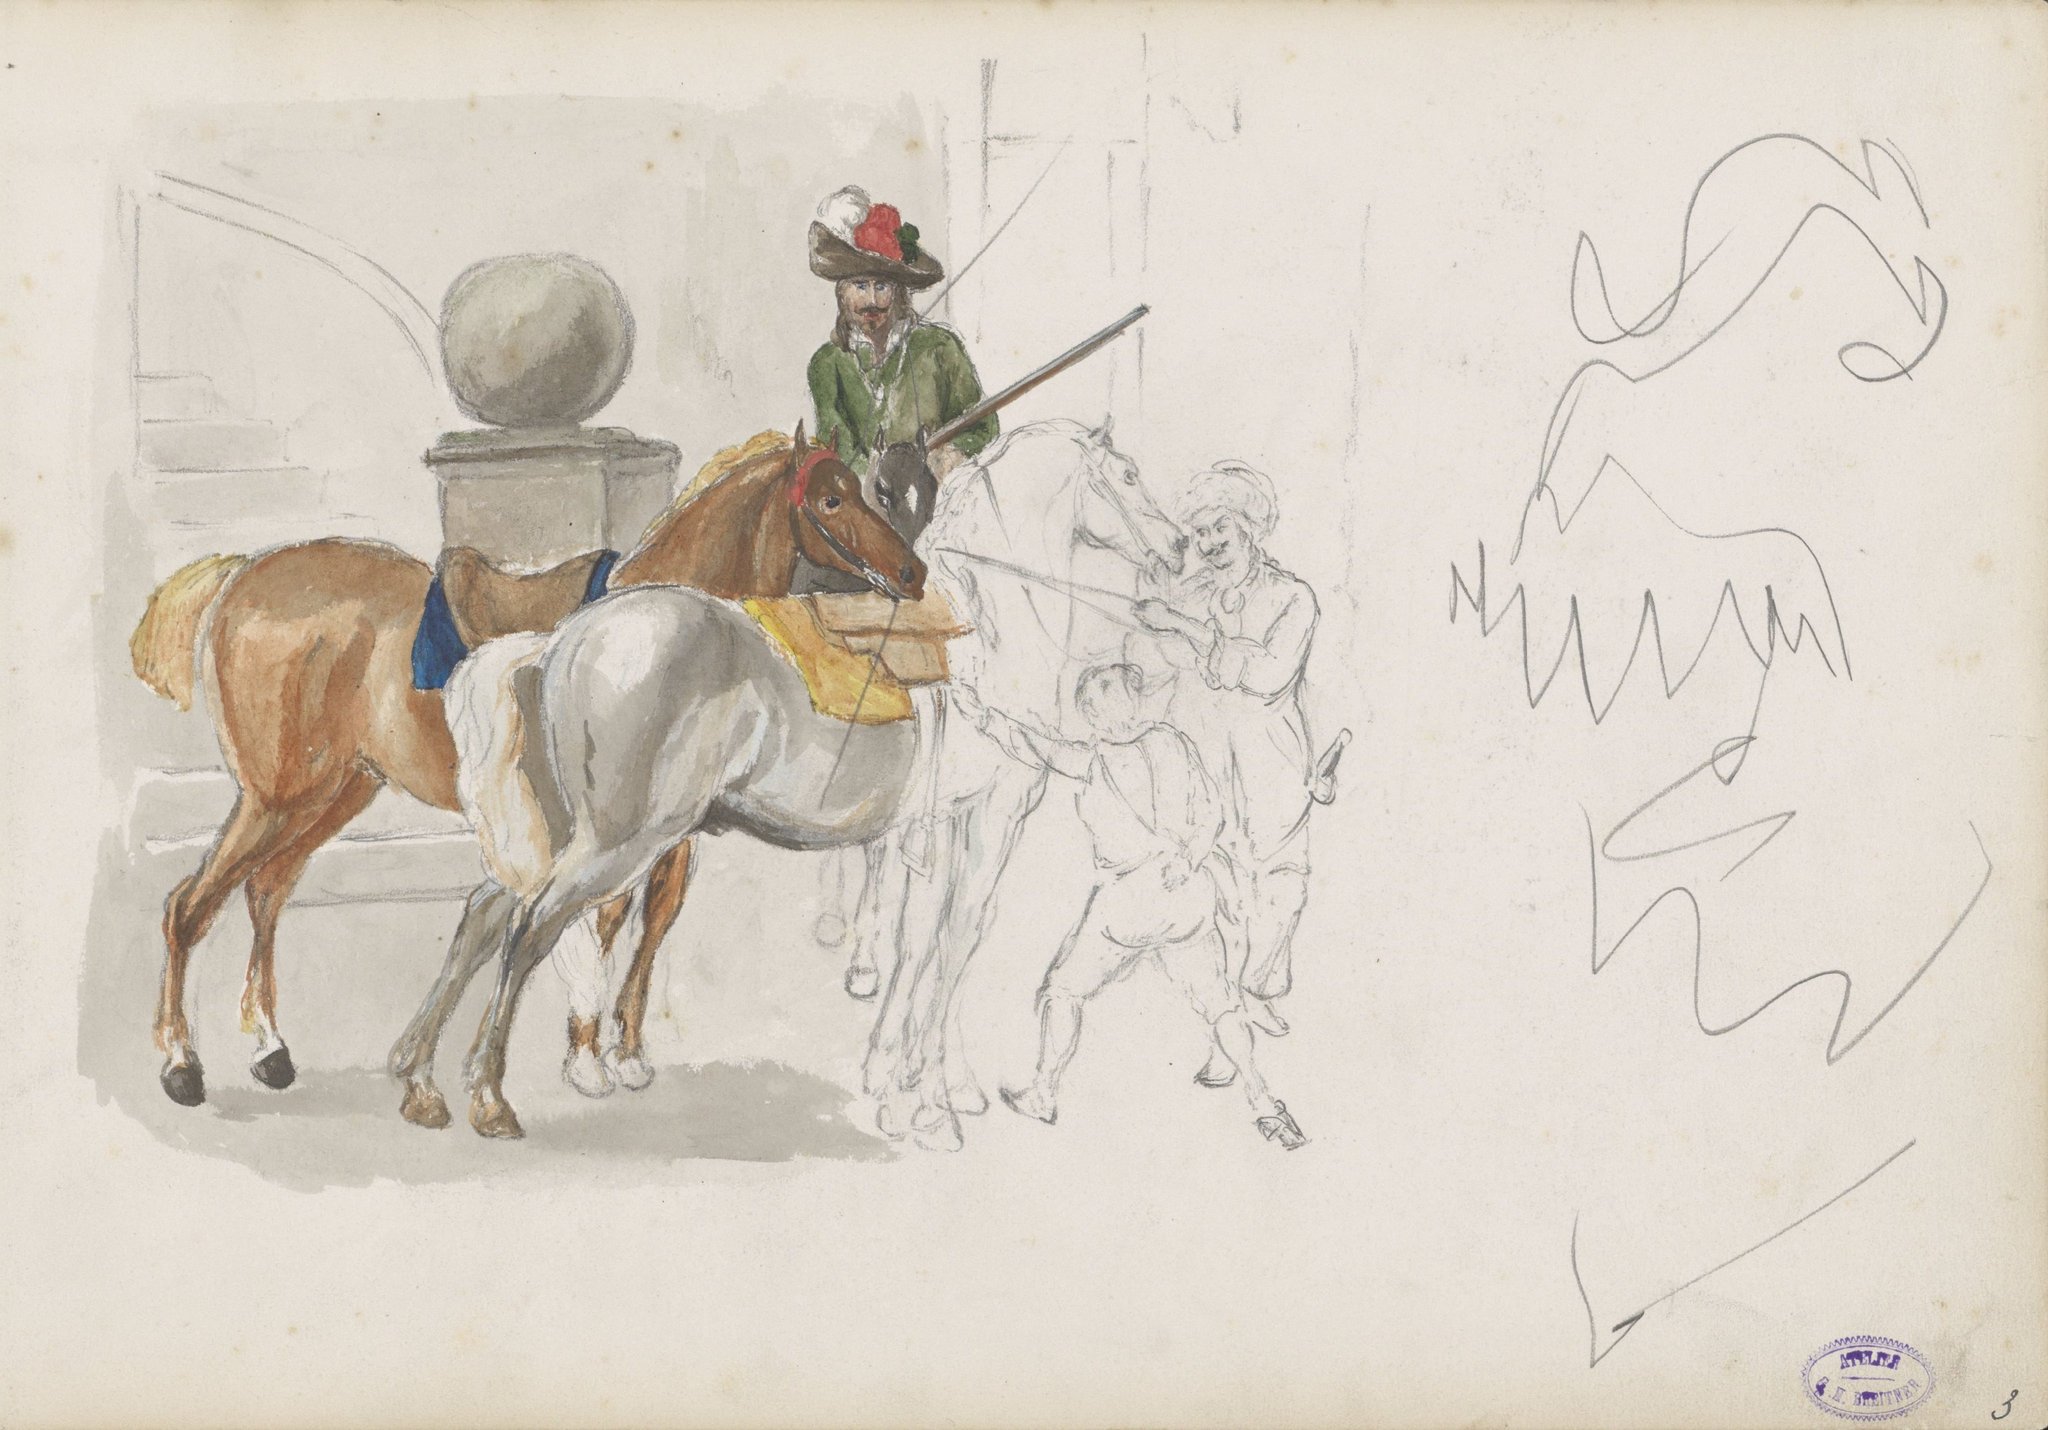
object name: drawing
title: Drie mannen en een jongen bij drie paarden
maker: george hendrik breitner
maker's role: draughtsman, painter, print maker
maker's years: 1857-1923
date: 1873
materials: paper, pencil, watercolor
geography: rotterdam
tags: staircase, horse, the soldier; the soldier's life (+ cavalry, horsemen)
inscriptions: workshop stamp: Lugt 291d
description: Een man met een geweer zit op een paard. De jongen en de andere man staan naast het paard en houden het in bedwang. Achter hen een trap.